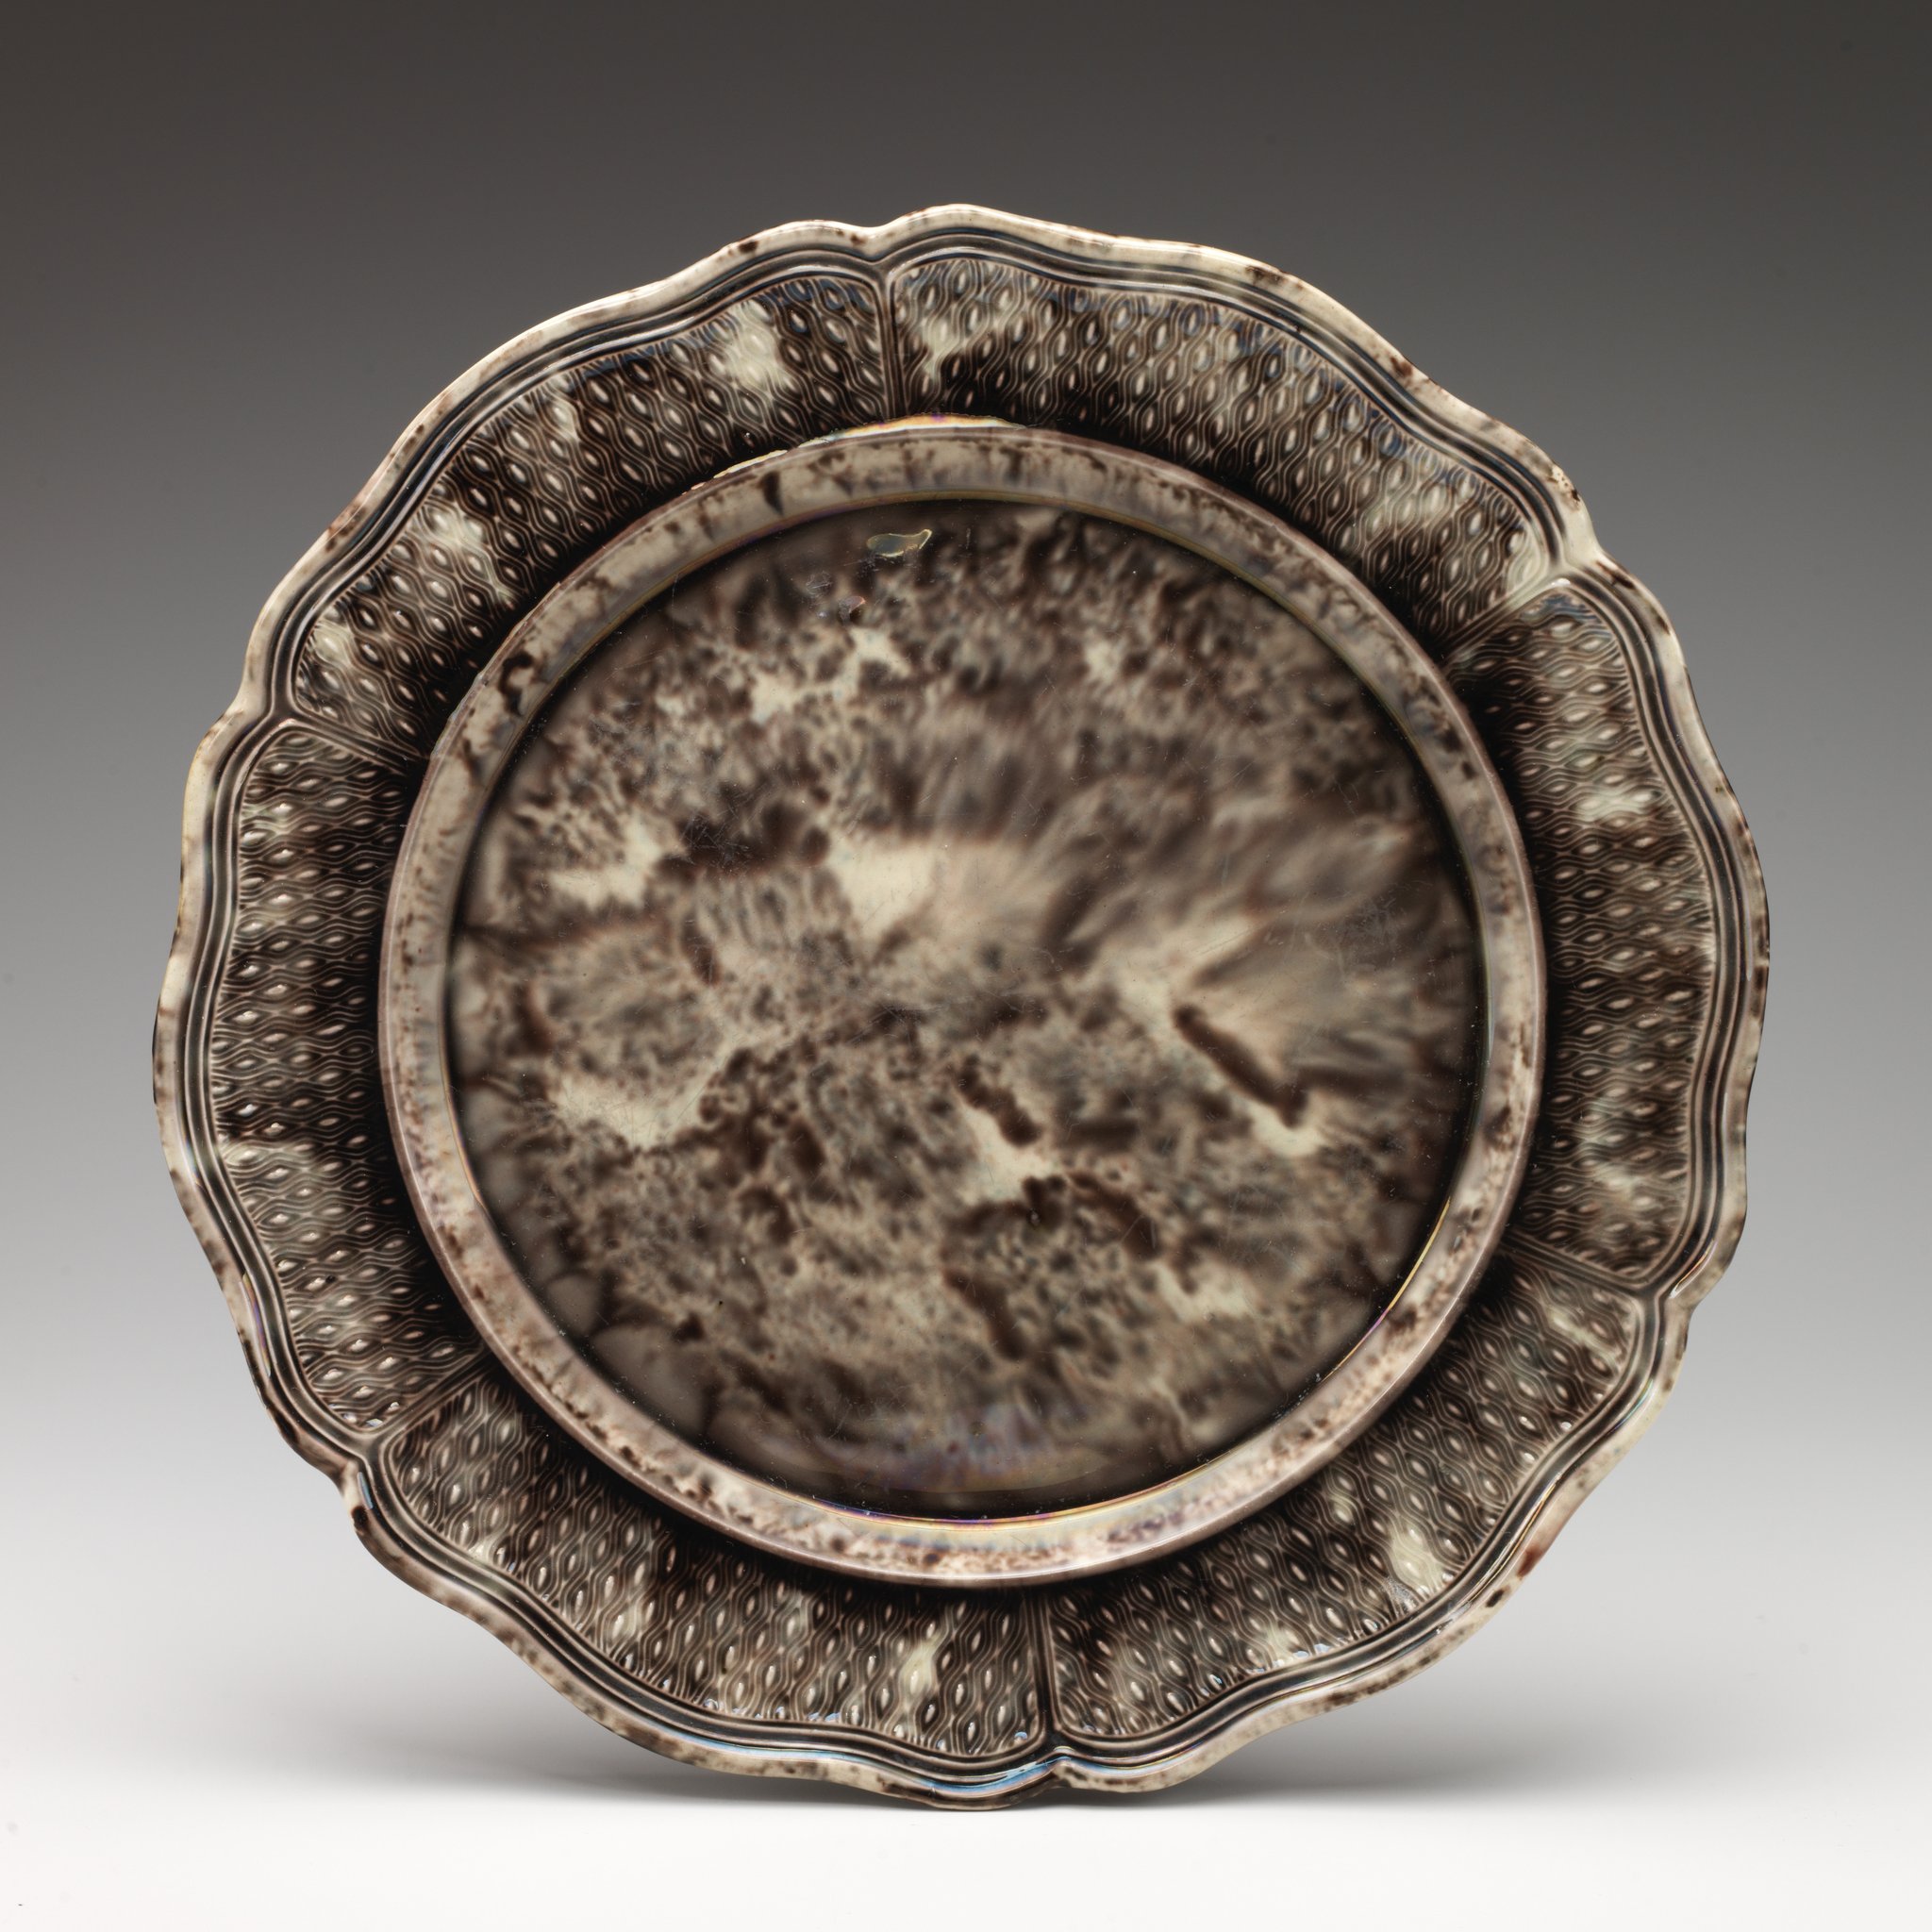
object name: plate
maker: whieldon type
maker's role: maker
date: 1751-1800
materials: earthenware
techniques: glazing